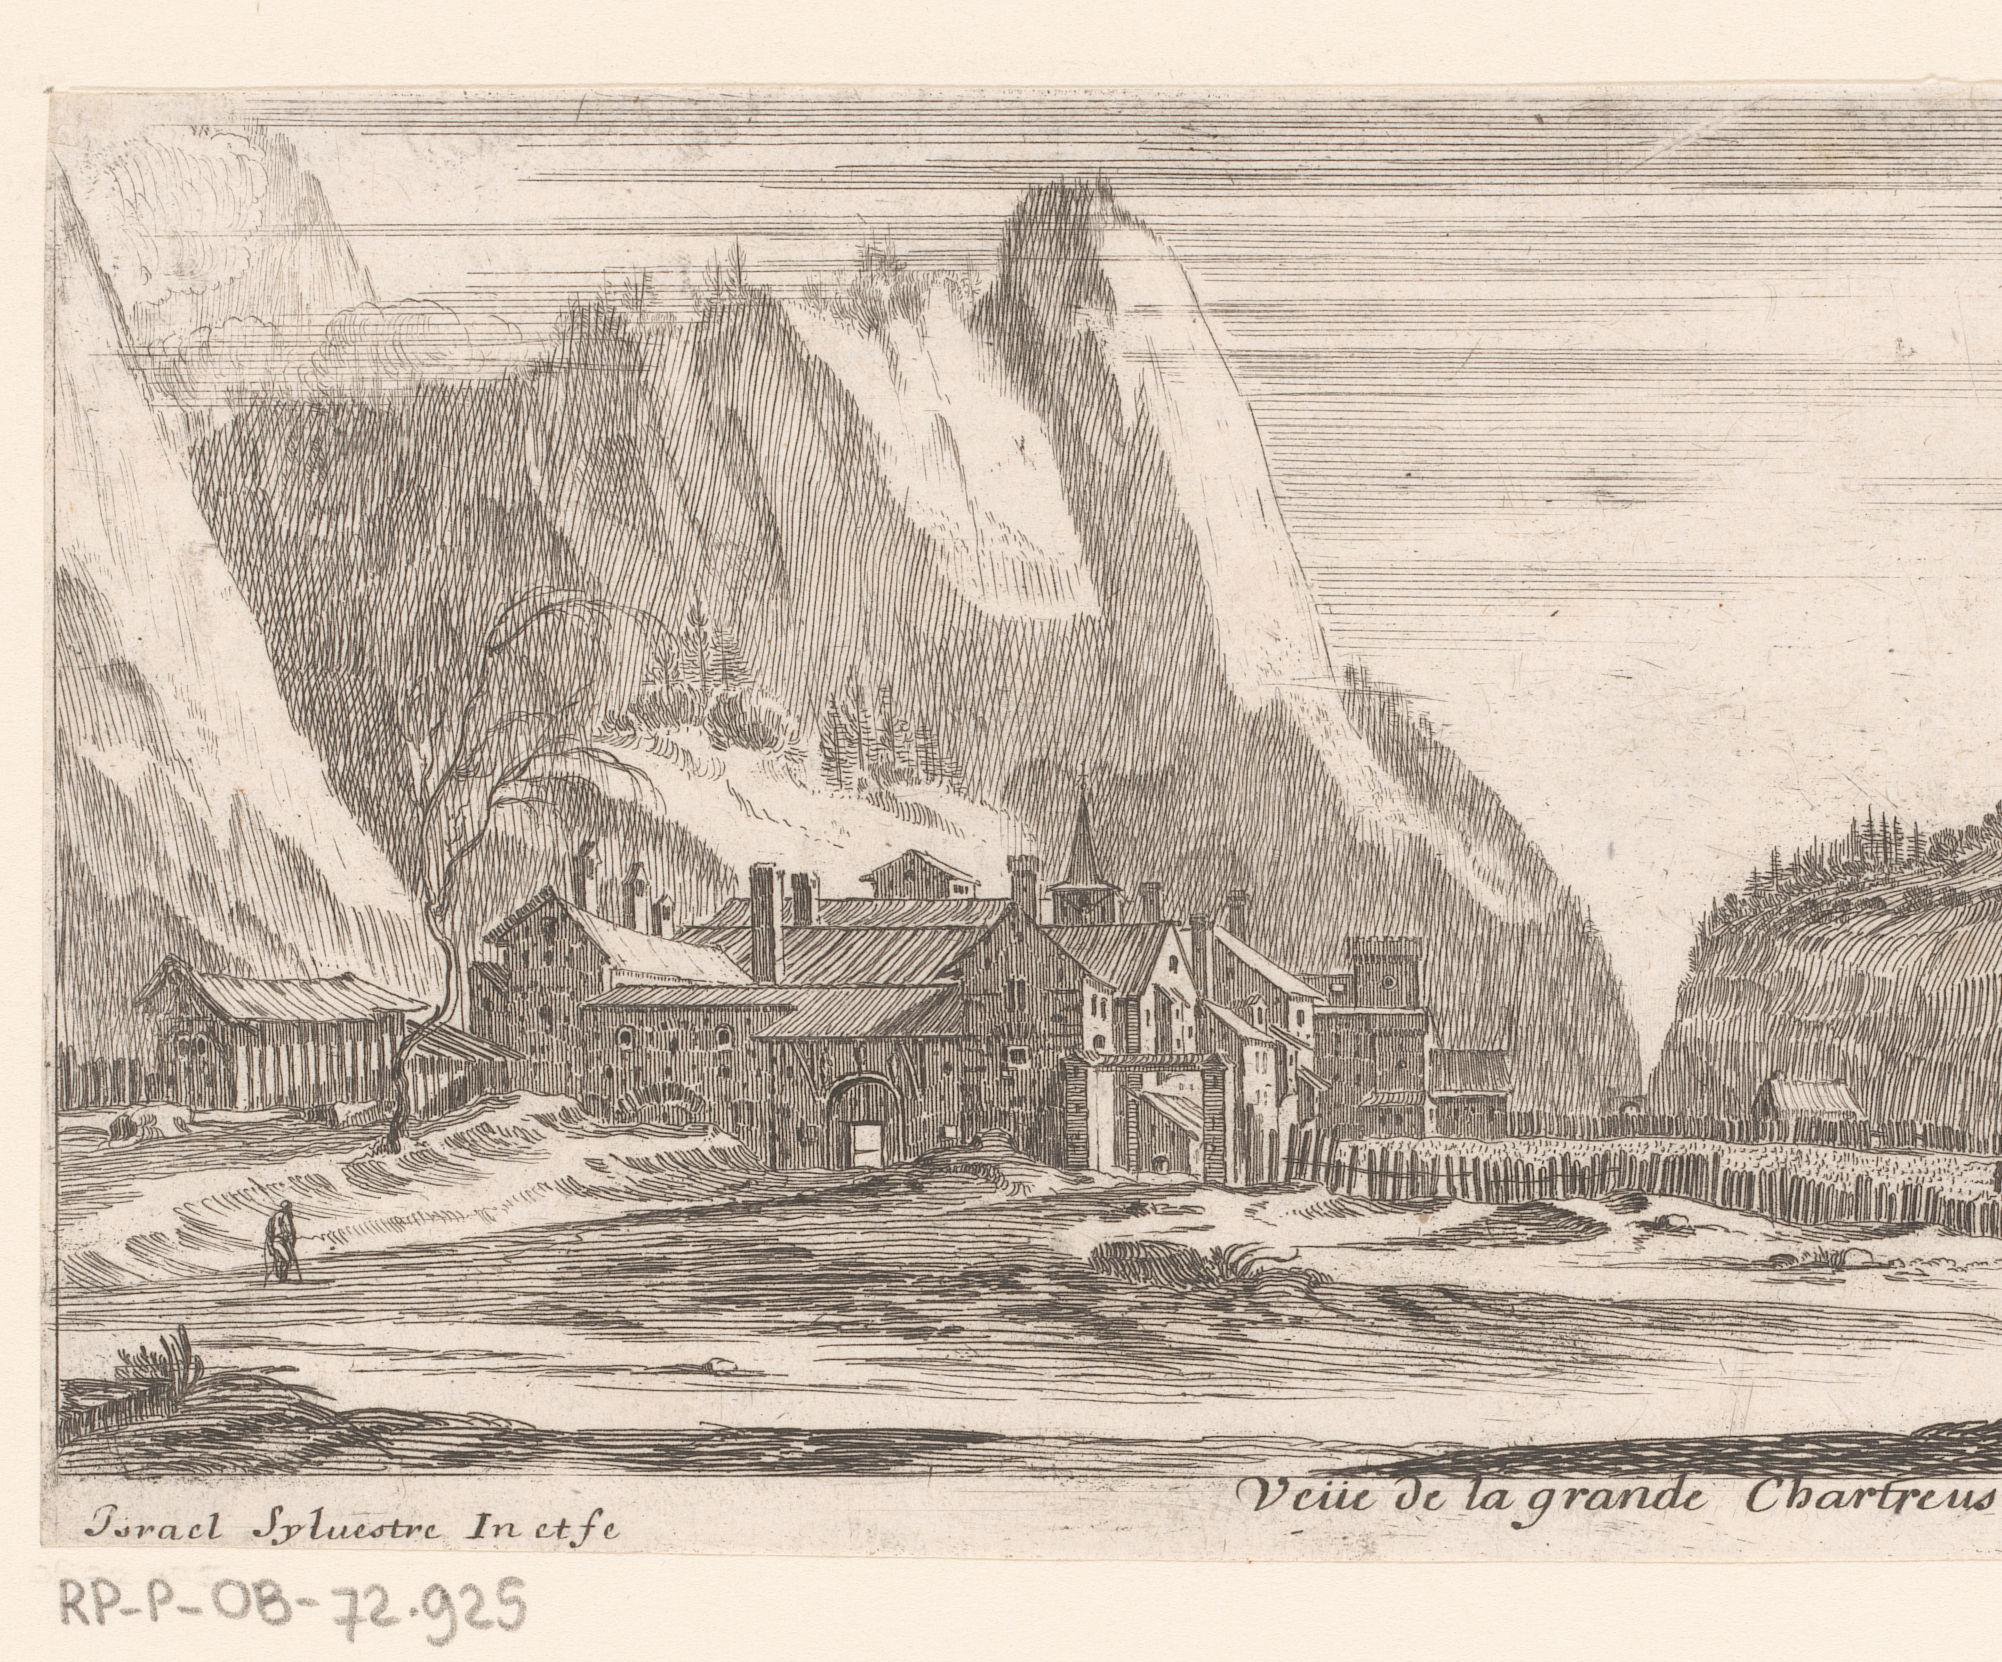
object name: print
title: Vues d'Italie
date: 1631-1675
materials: paper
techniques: engraving, etching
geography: france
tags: abbey, monastery, convent ~ roman catholic church, mountains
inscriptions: collector's mark: Lugt 240